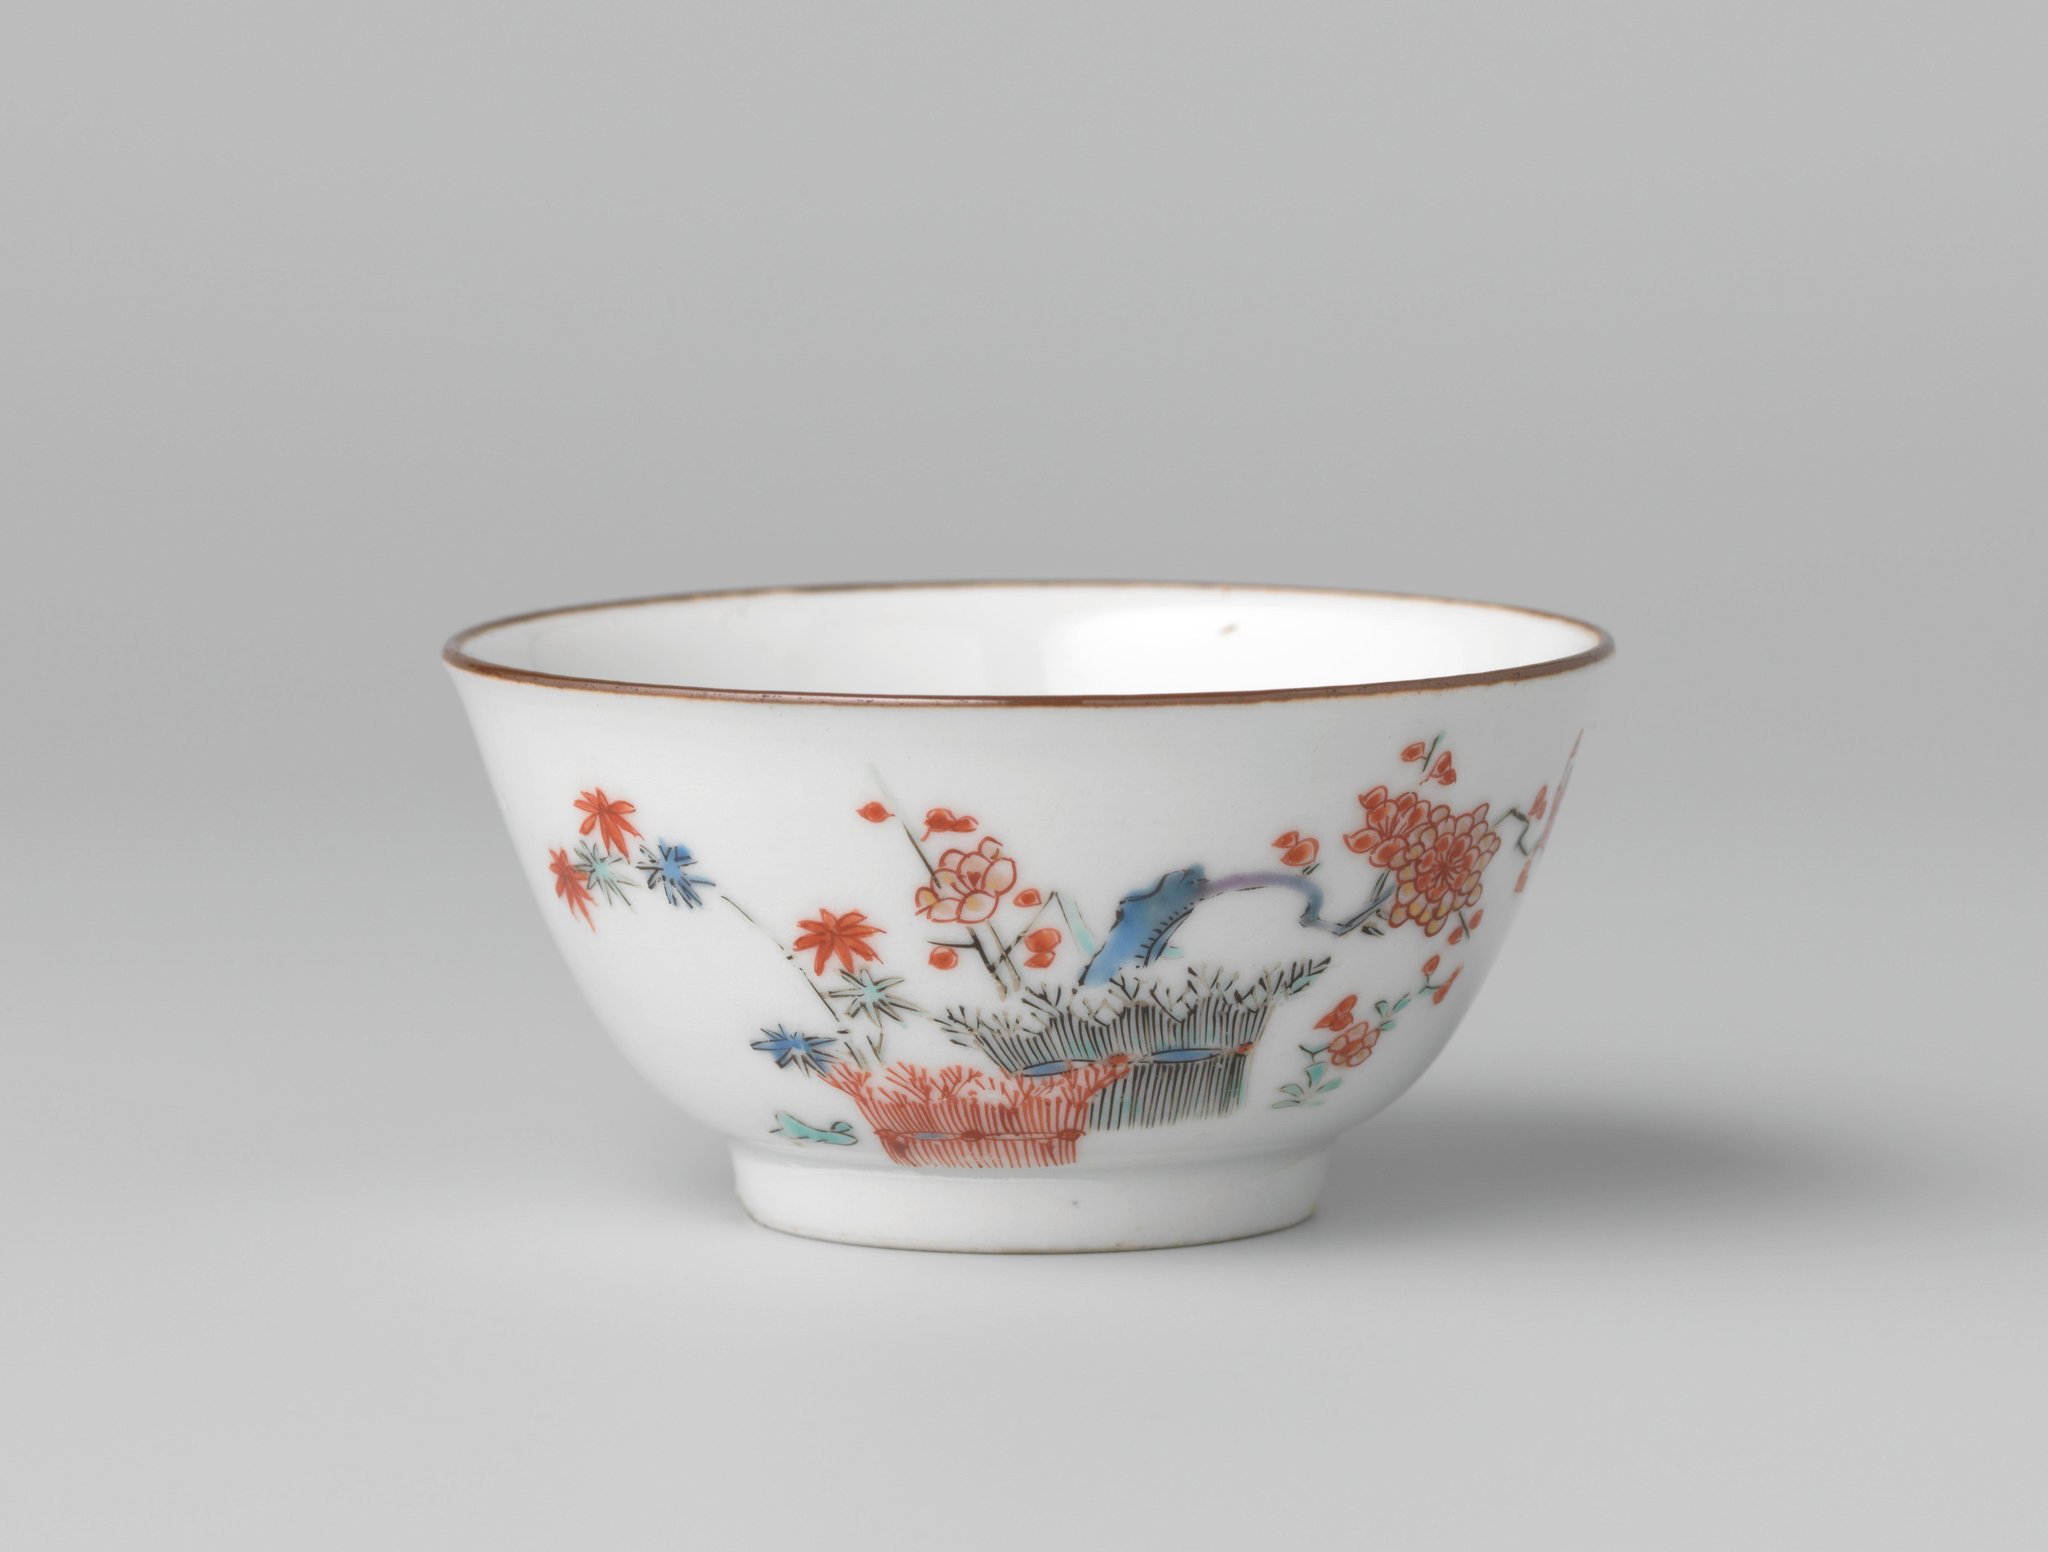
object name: cup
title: Cup with hedges, bamboo, prunus and hoo-bird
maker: Anonymous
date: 1670-1690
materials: glaze, gold, paint, porcelain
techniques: firing, gilding, turning, vitrification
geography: japan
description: Kop zonder oor, van porselein, beschilderd in blauw, rood, groen, geel, zwart en goud met bamboe, prunus en nog een plant bij gebonden heggen, en en ho-ho-vogel. Bruine rand. Kakiemondecor